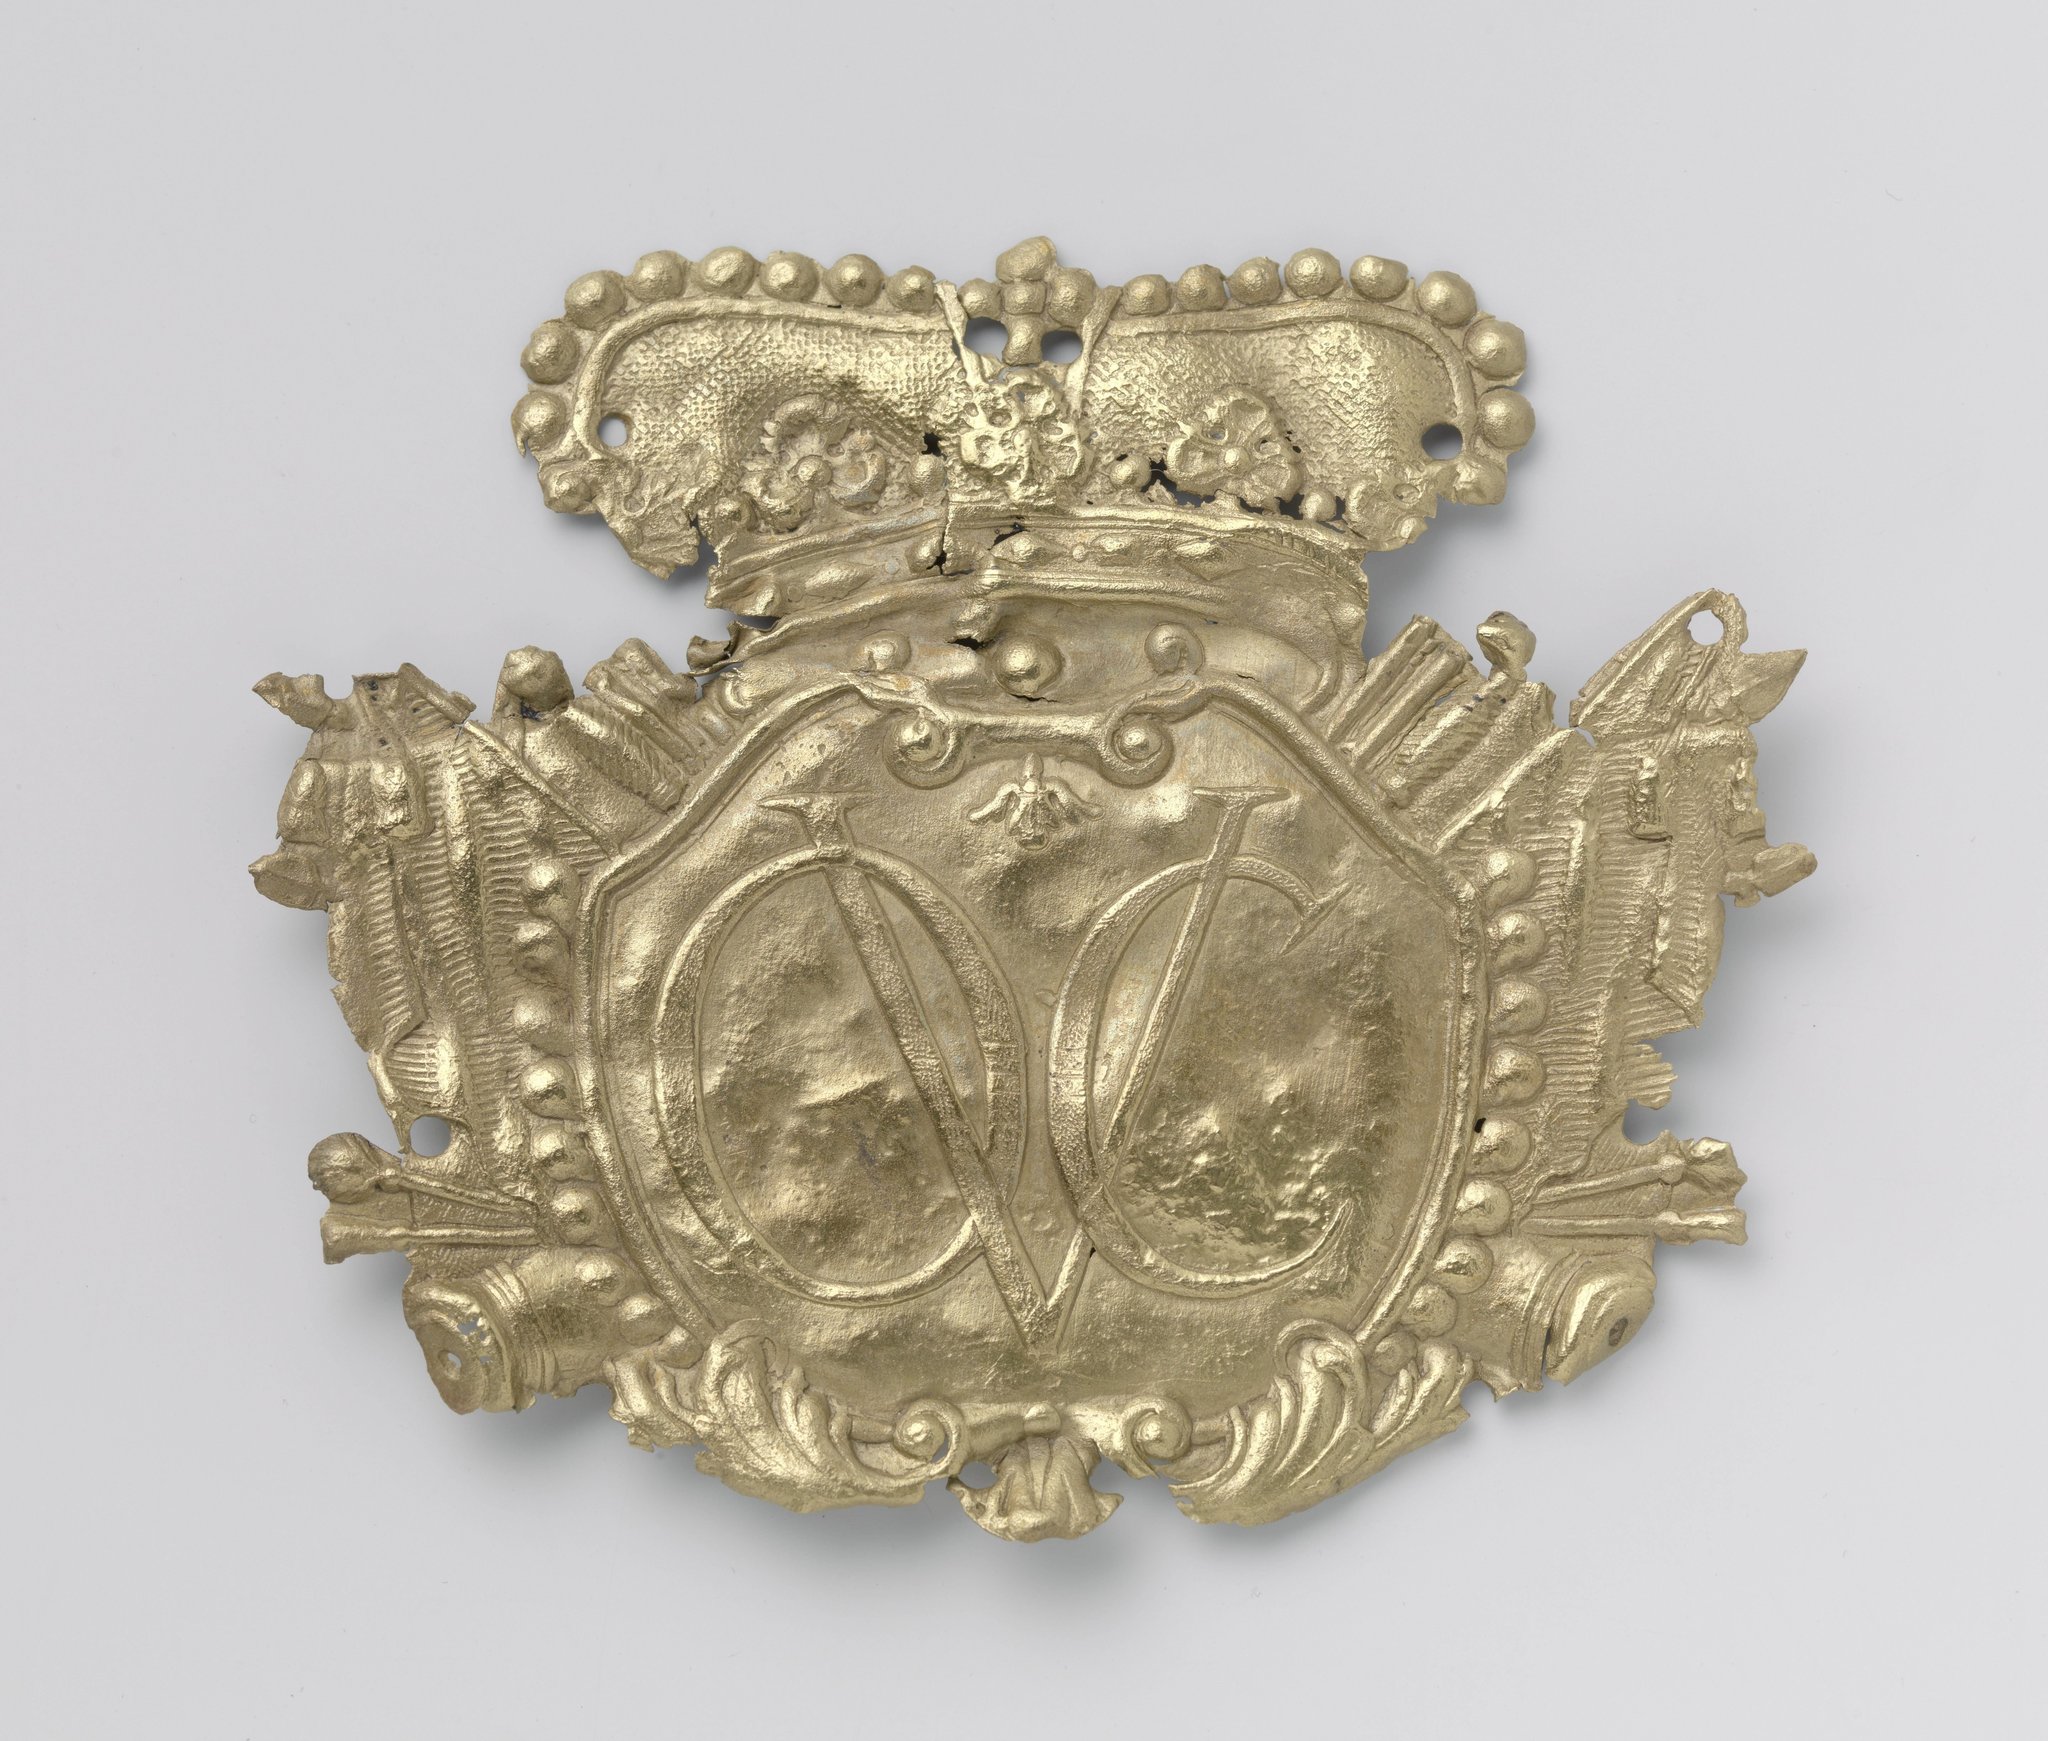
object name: insignia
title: Military Insignia of musketeer or grenadiers from the wreck of the Dutch East Indiaman Hollandia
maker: Anonymous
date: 1700-1743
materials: copper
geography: netherlands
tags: verenigde oostindische compagnie, hollandia (schip), annet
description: Badge, military; id. NG-1975-19-H-345/1113.